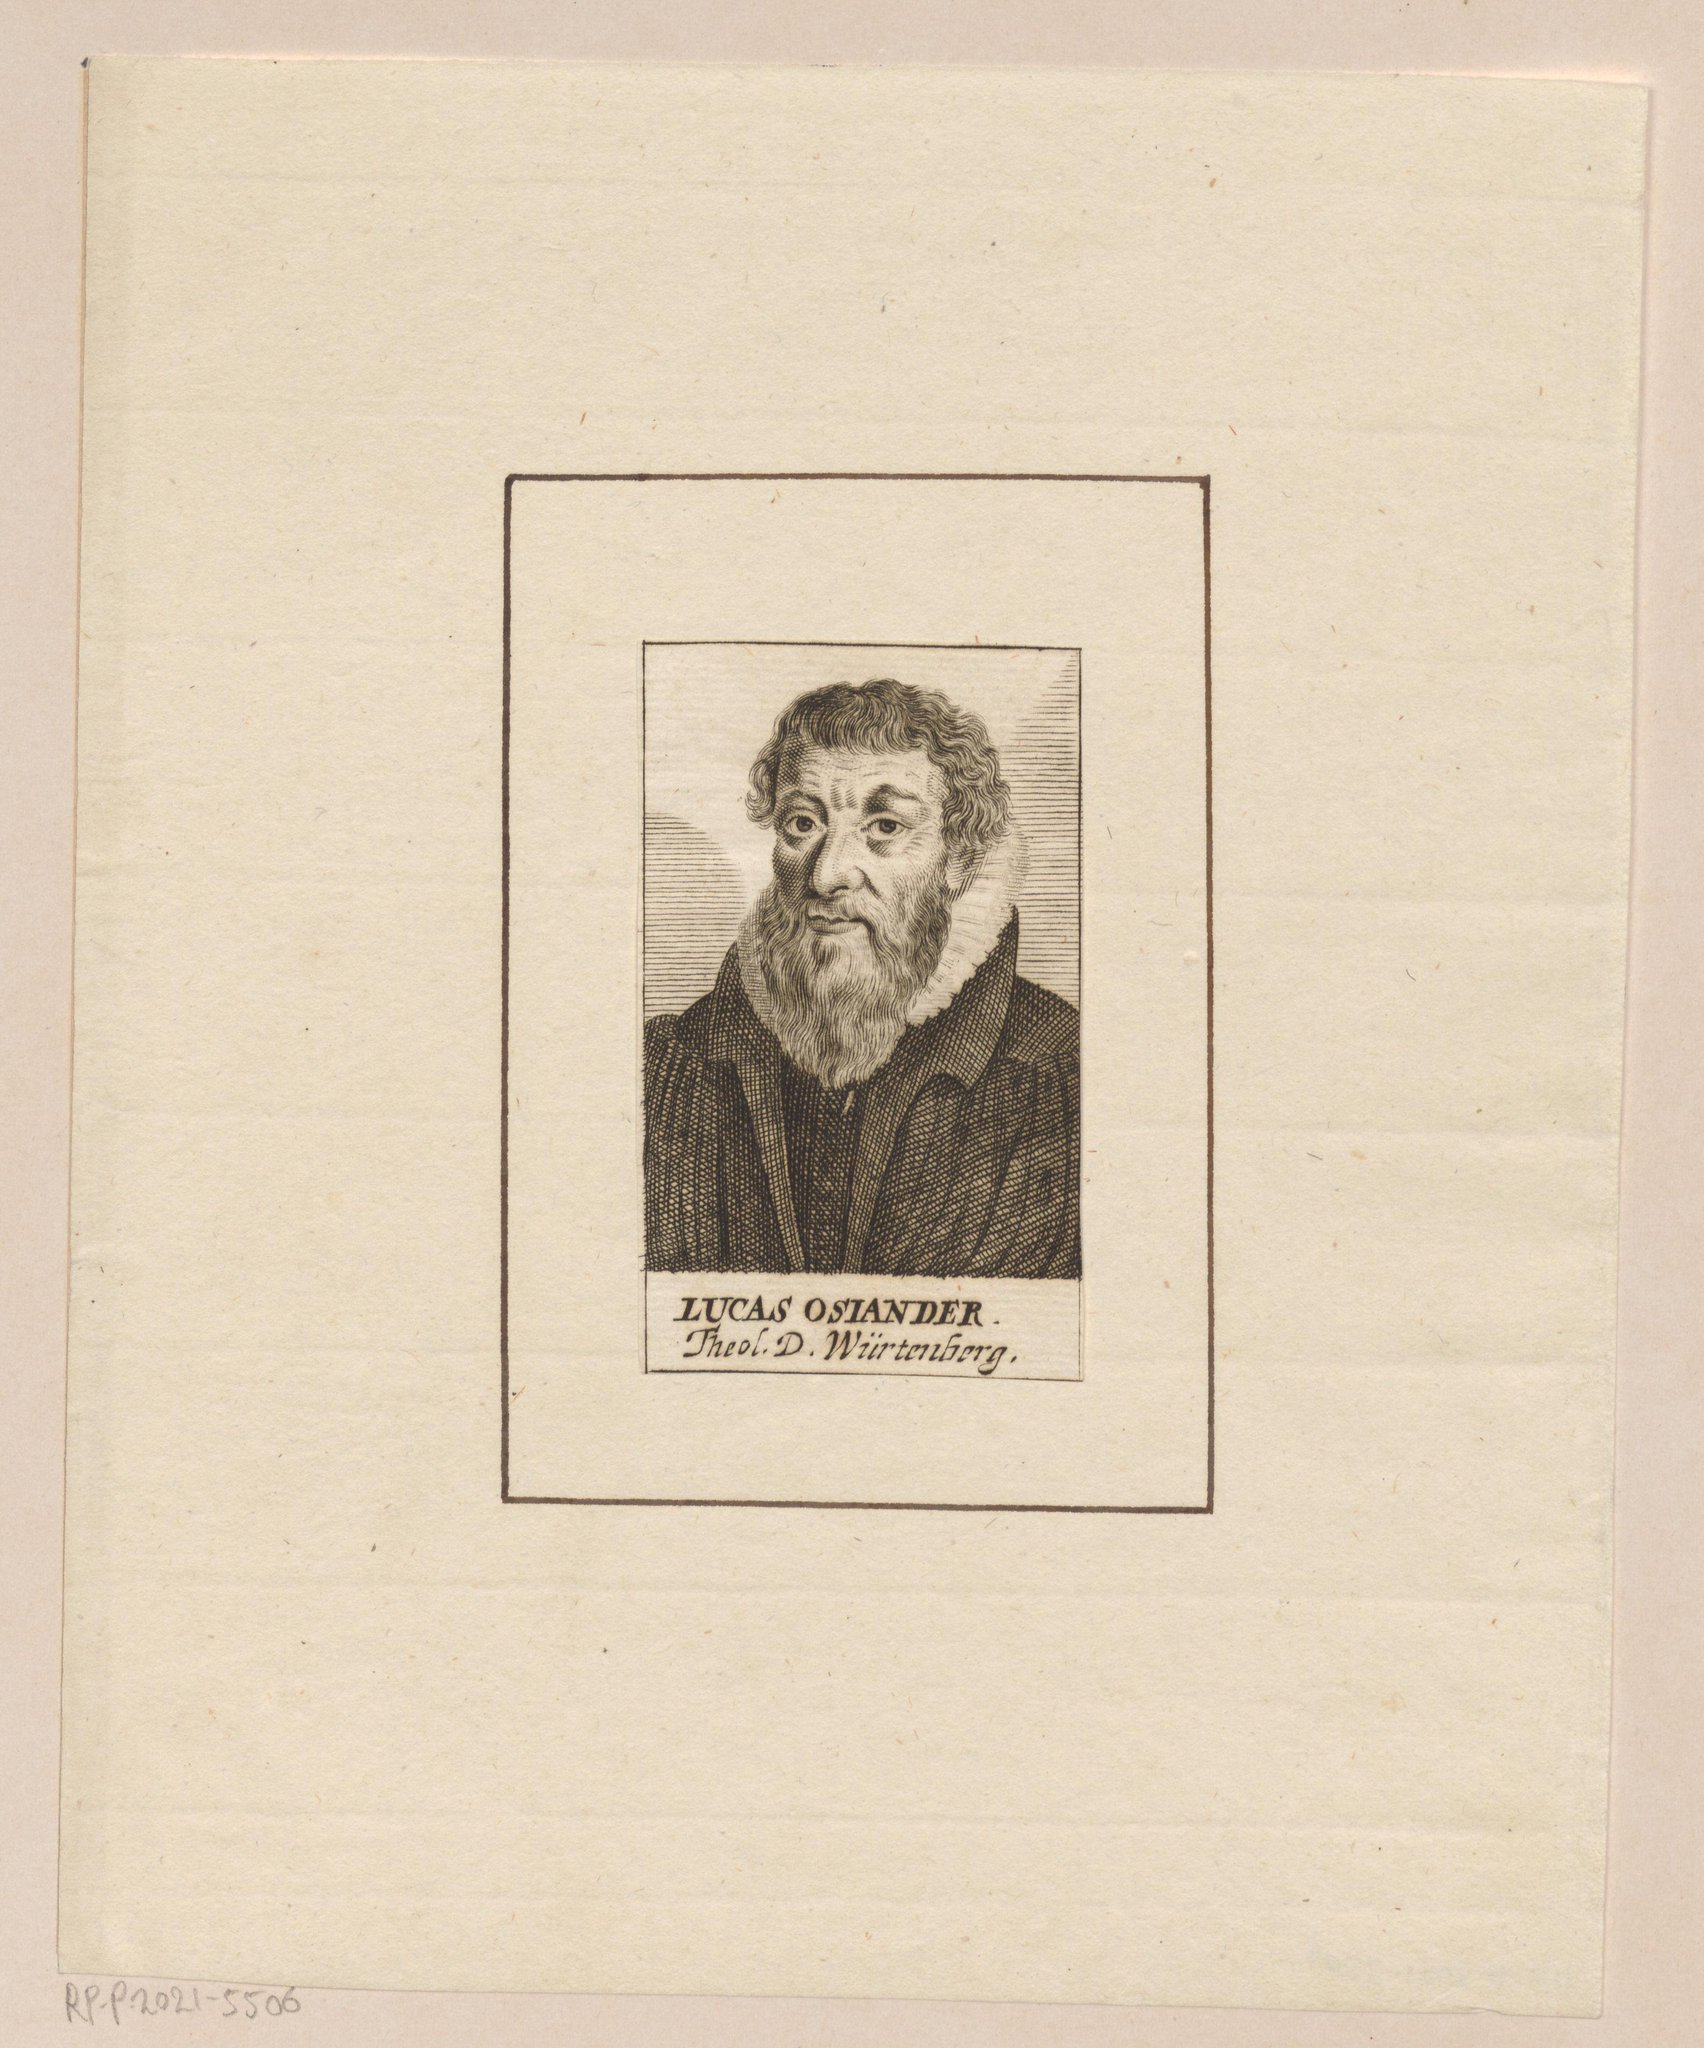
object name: print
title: Portret van Lucas Osiander I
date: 1688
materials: paper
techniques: engraving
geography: nuremberg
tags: historical persons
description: Prent mogelijk uit: Freher, Paul. Theatrum virorum eruditione clarorum. Neurenberg: Johann Hoffmann, 1688.